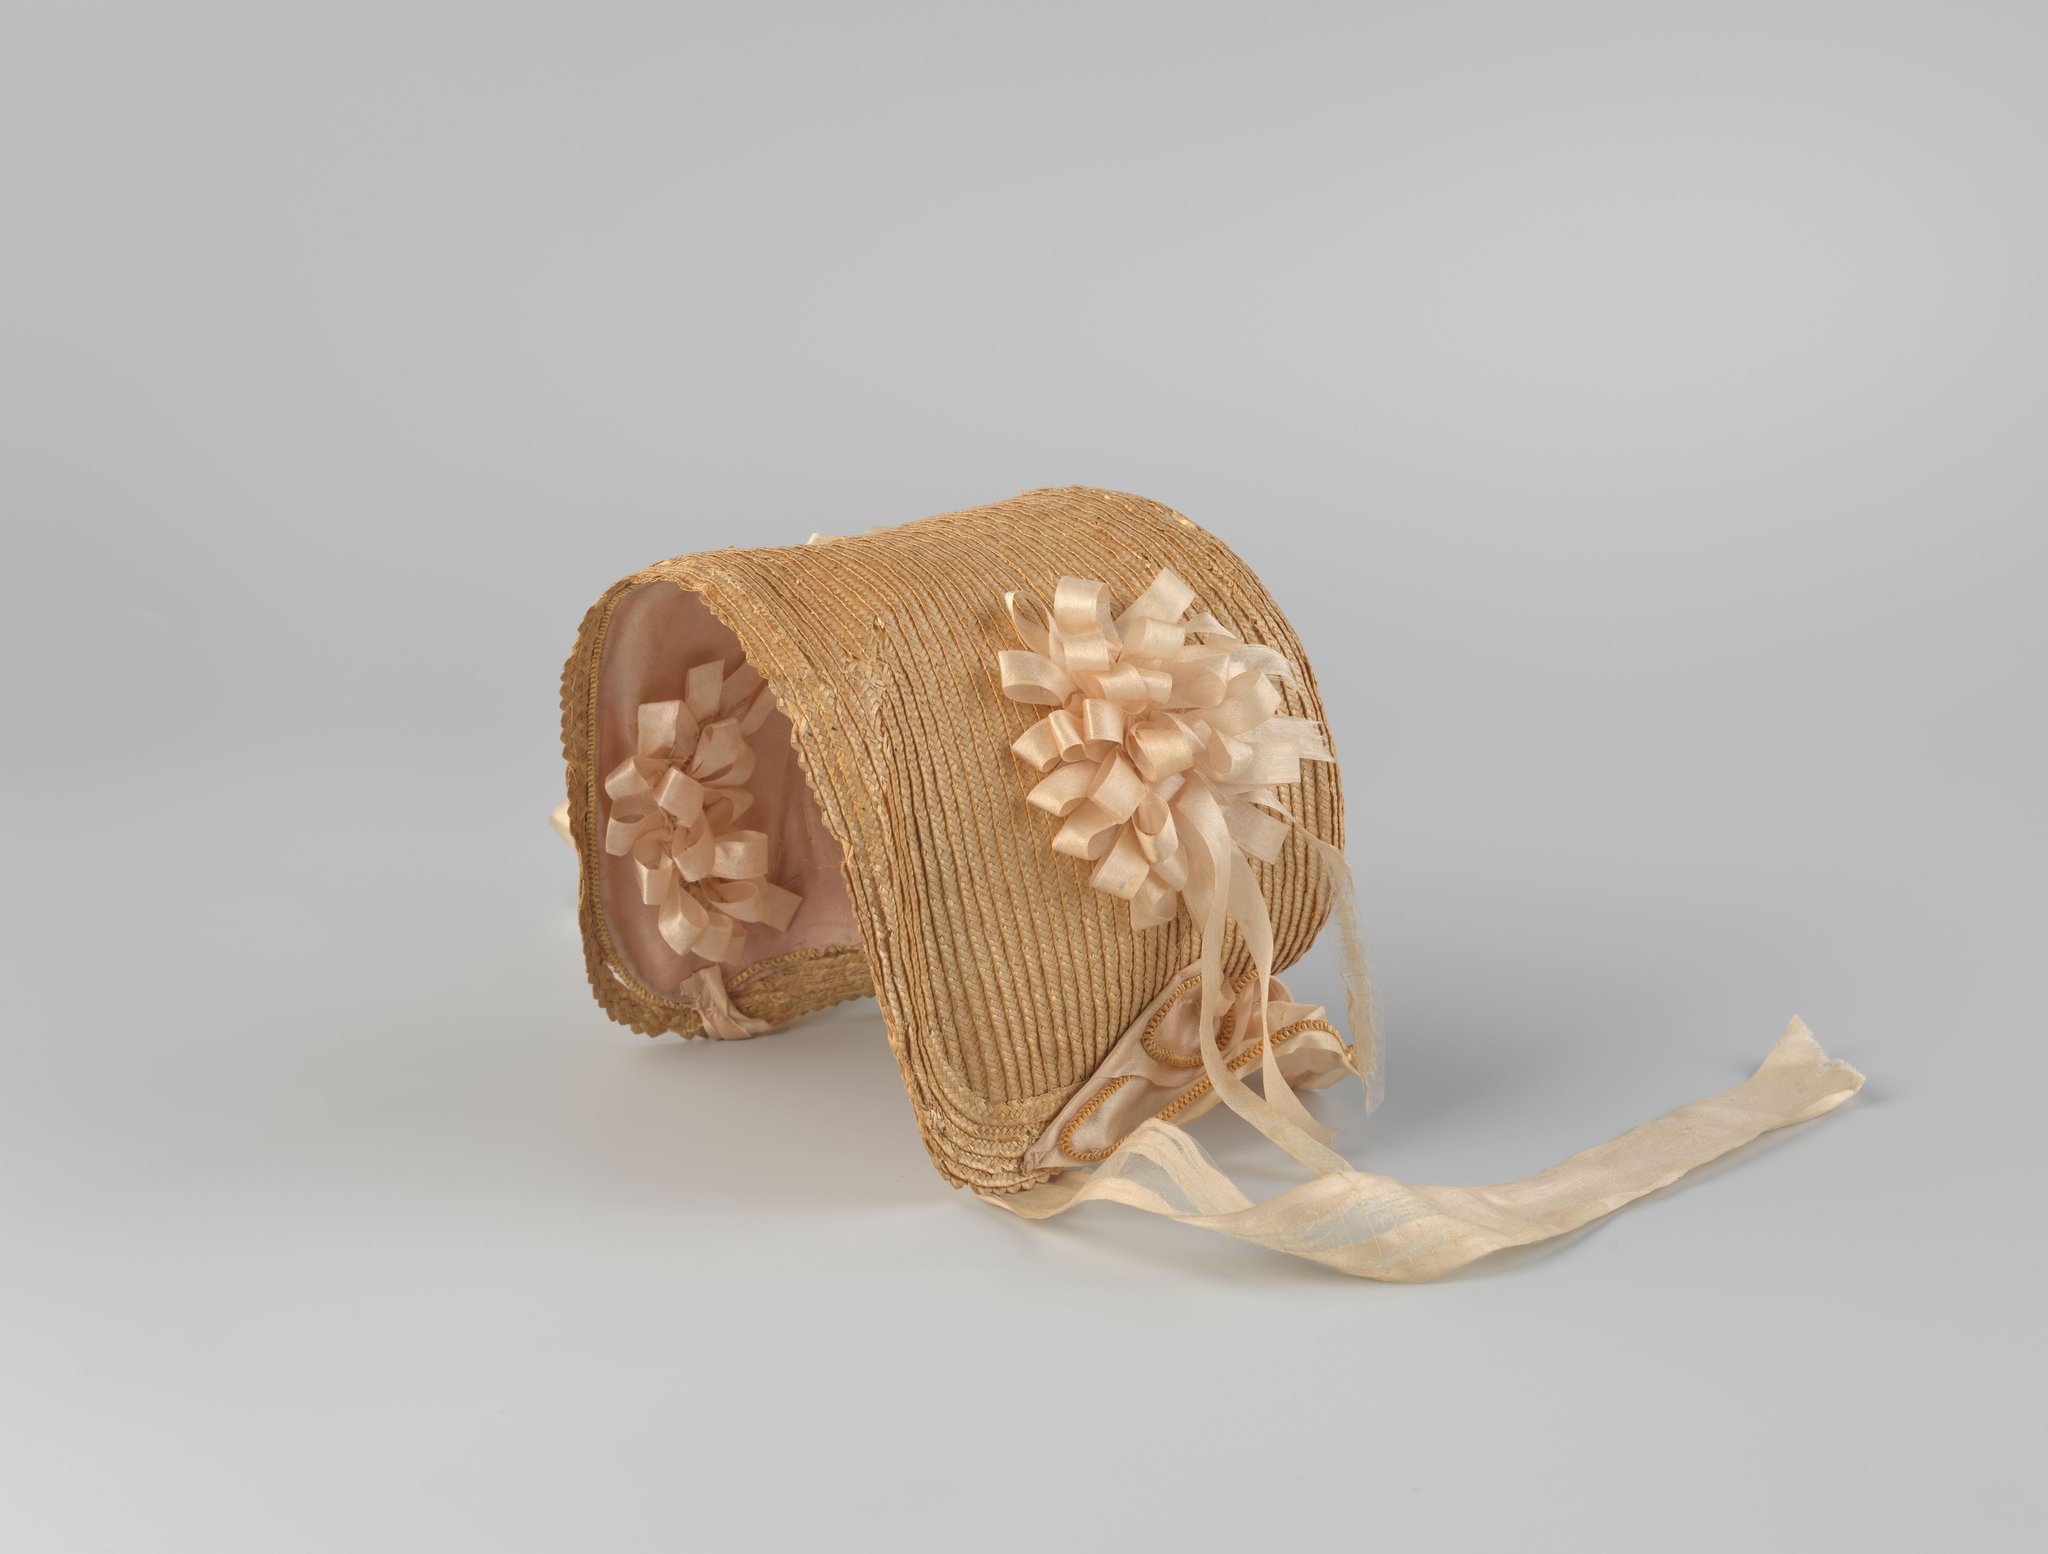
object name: doll's clothing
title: Poppeluifelhoed van beige tafzijde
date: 1830-1840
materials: textile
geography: netherlands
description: Poppeluifelhoed van beige tafzijde, rand gevoerd met aangerimpeld strookjes blauwe zijde. Aan beide kanten een toef lussen. Onder langs de rand een voalns met twee oprijgjes. deze rand heeft een grof gazen beleg. Linten om vast te strikken. Rond de bol resten van een beleg of voering. In de bol hoedenmakers gaas. Samen met poppeluifelhoed BK-1983-68-a in een hoededoos (BK-1983-68-c).